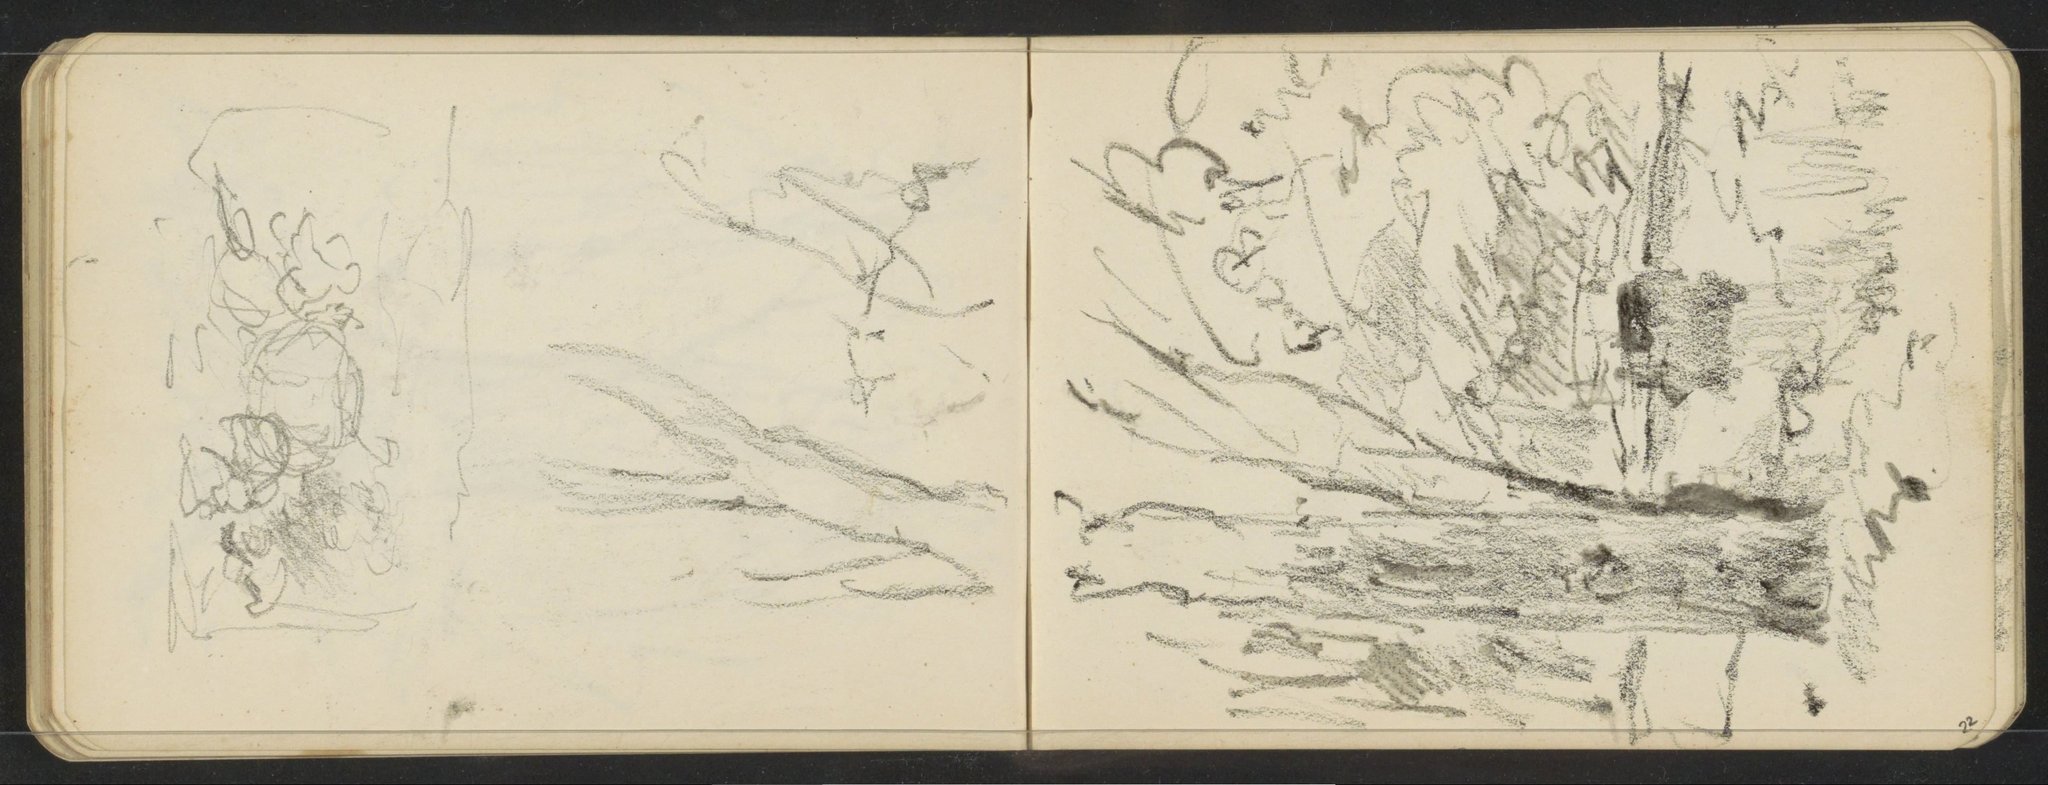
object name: sketchbook leaf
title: Bosrand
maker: willem cornelis rip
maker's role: draughtsman, painter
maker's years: 1856-1922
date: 1914-1916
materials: chalk, paper, pencil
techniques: brush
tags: fringe, edge of the wood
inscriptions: kleurnotitie, handgeschreven in zwart krijt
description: Blad 21 verso en 22 recto uit een schetsboek met 41 bladen.